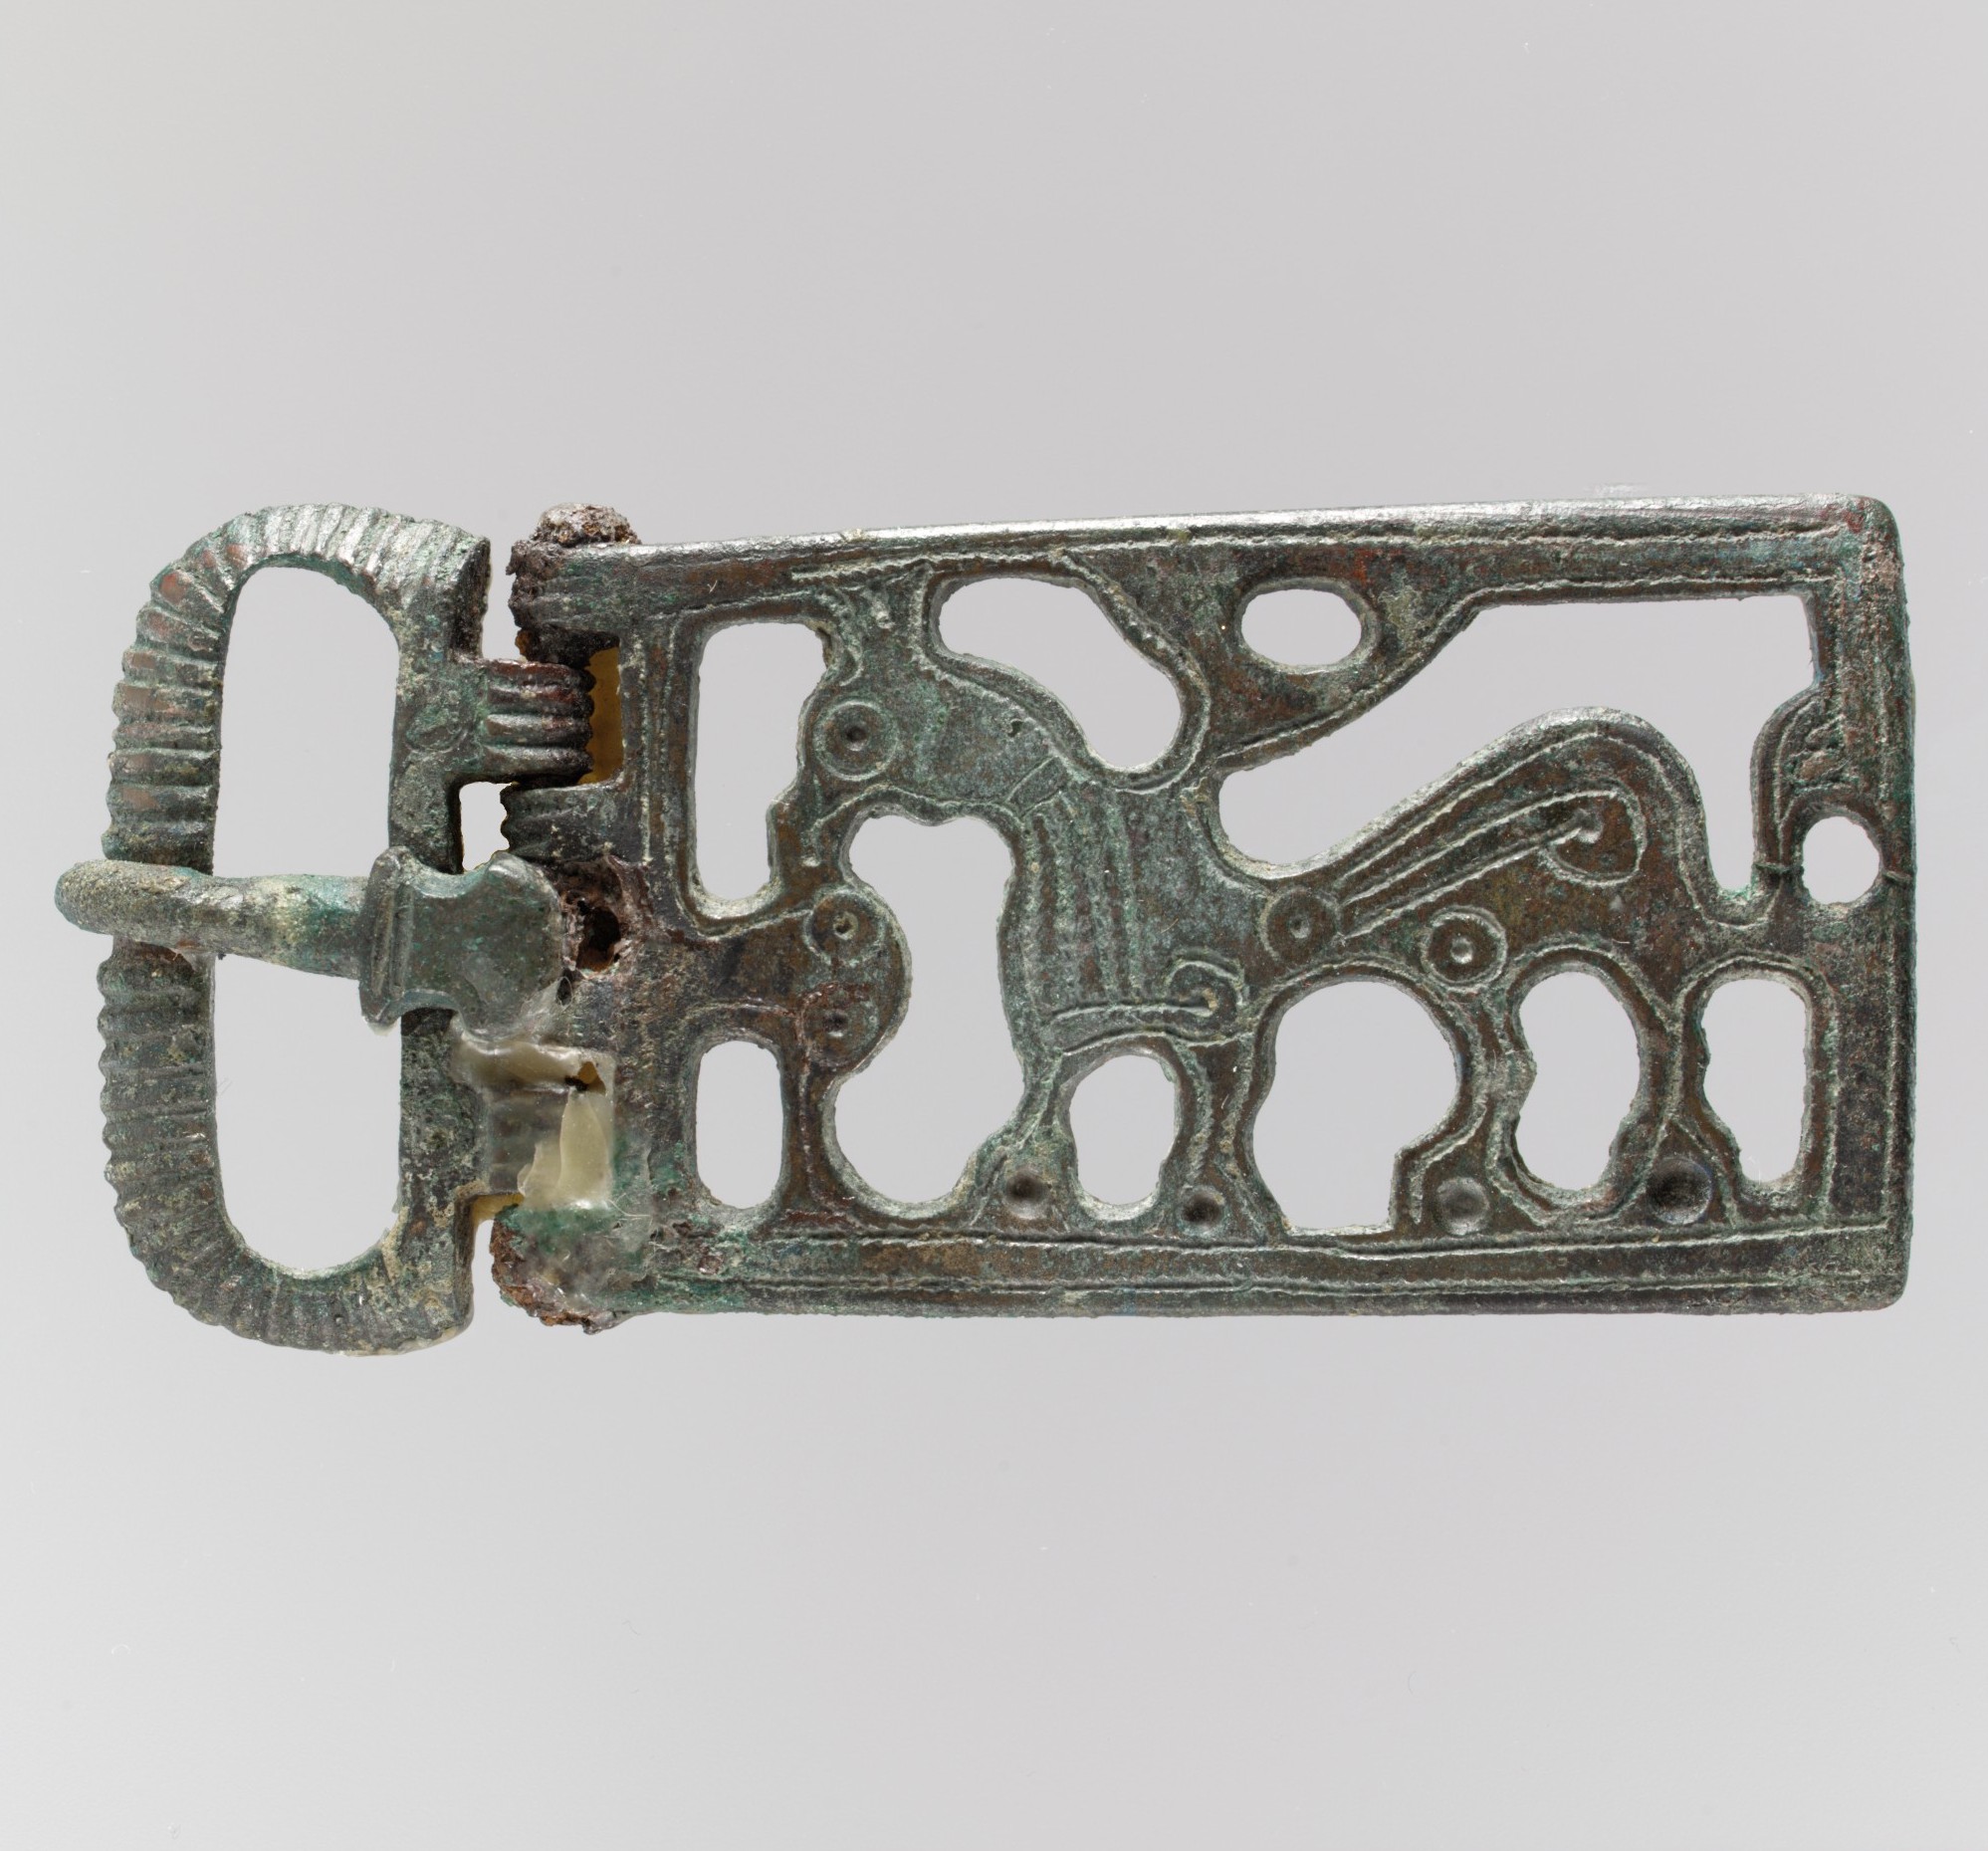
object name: buckle plaque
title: Belt Buckle with a Griffin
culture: frankish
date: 551-600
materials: copper alloy